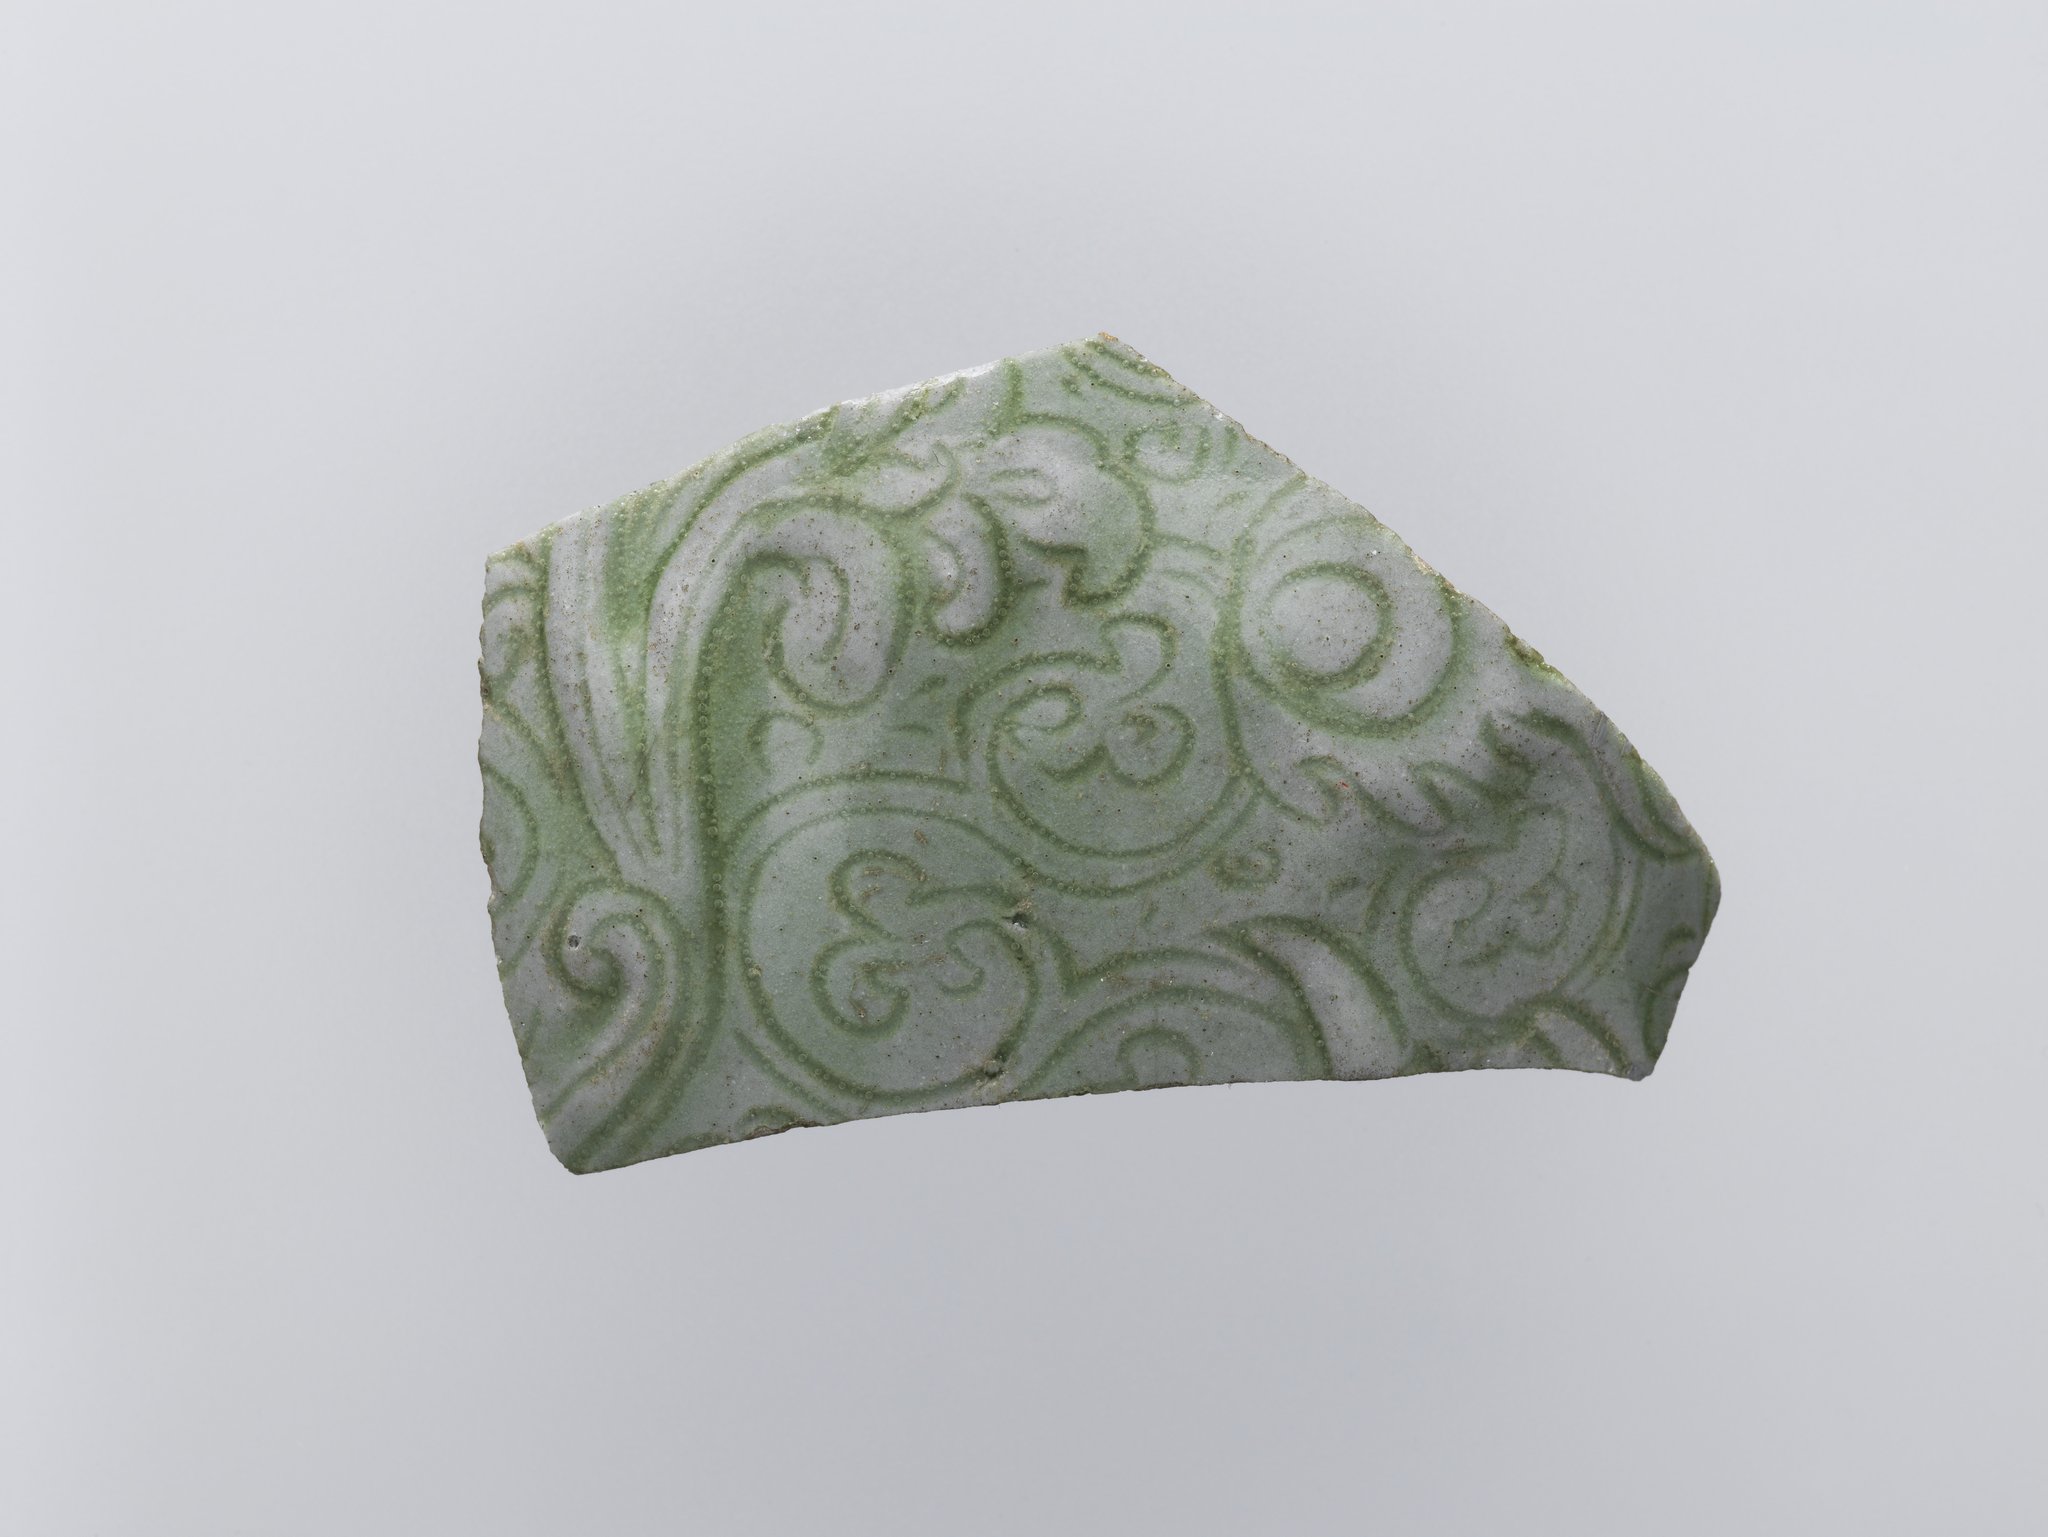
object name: sherd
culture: chinese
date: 960-1279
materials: stoneware